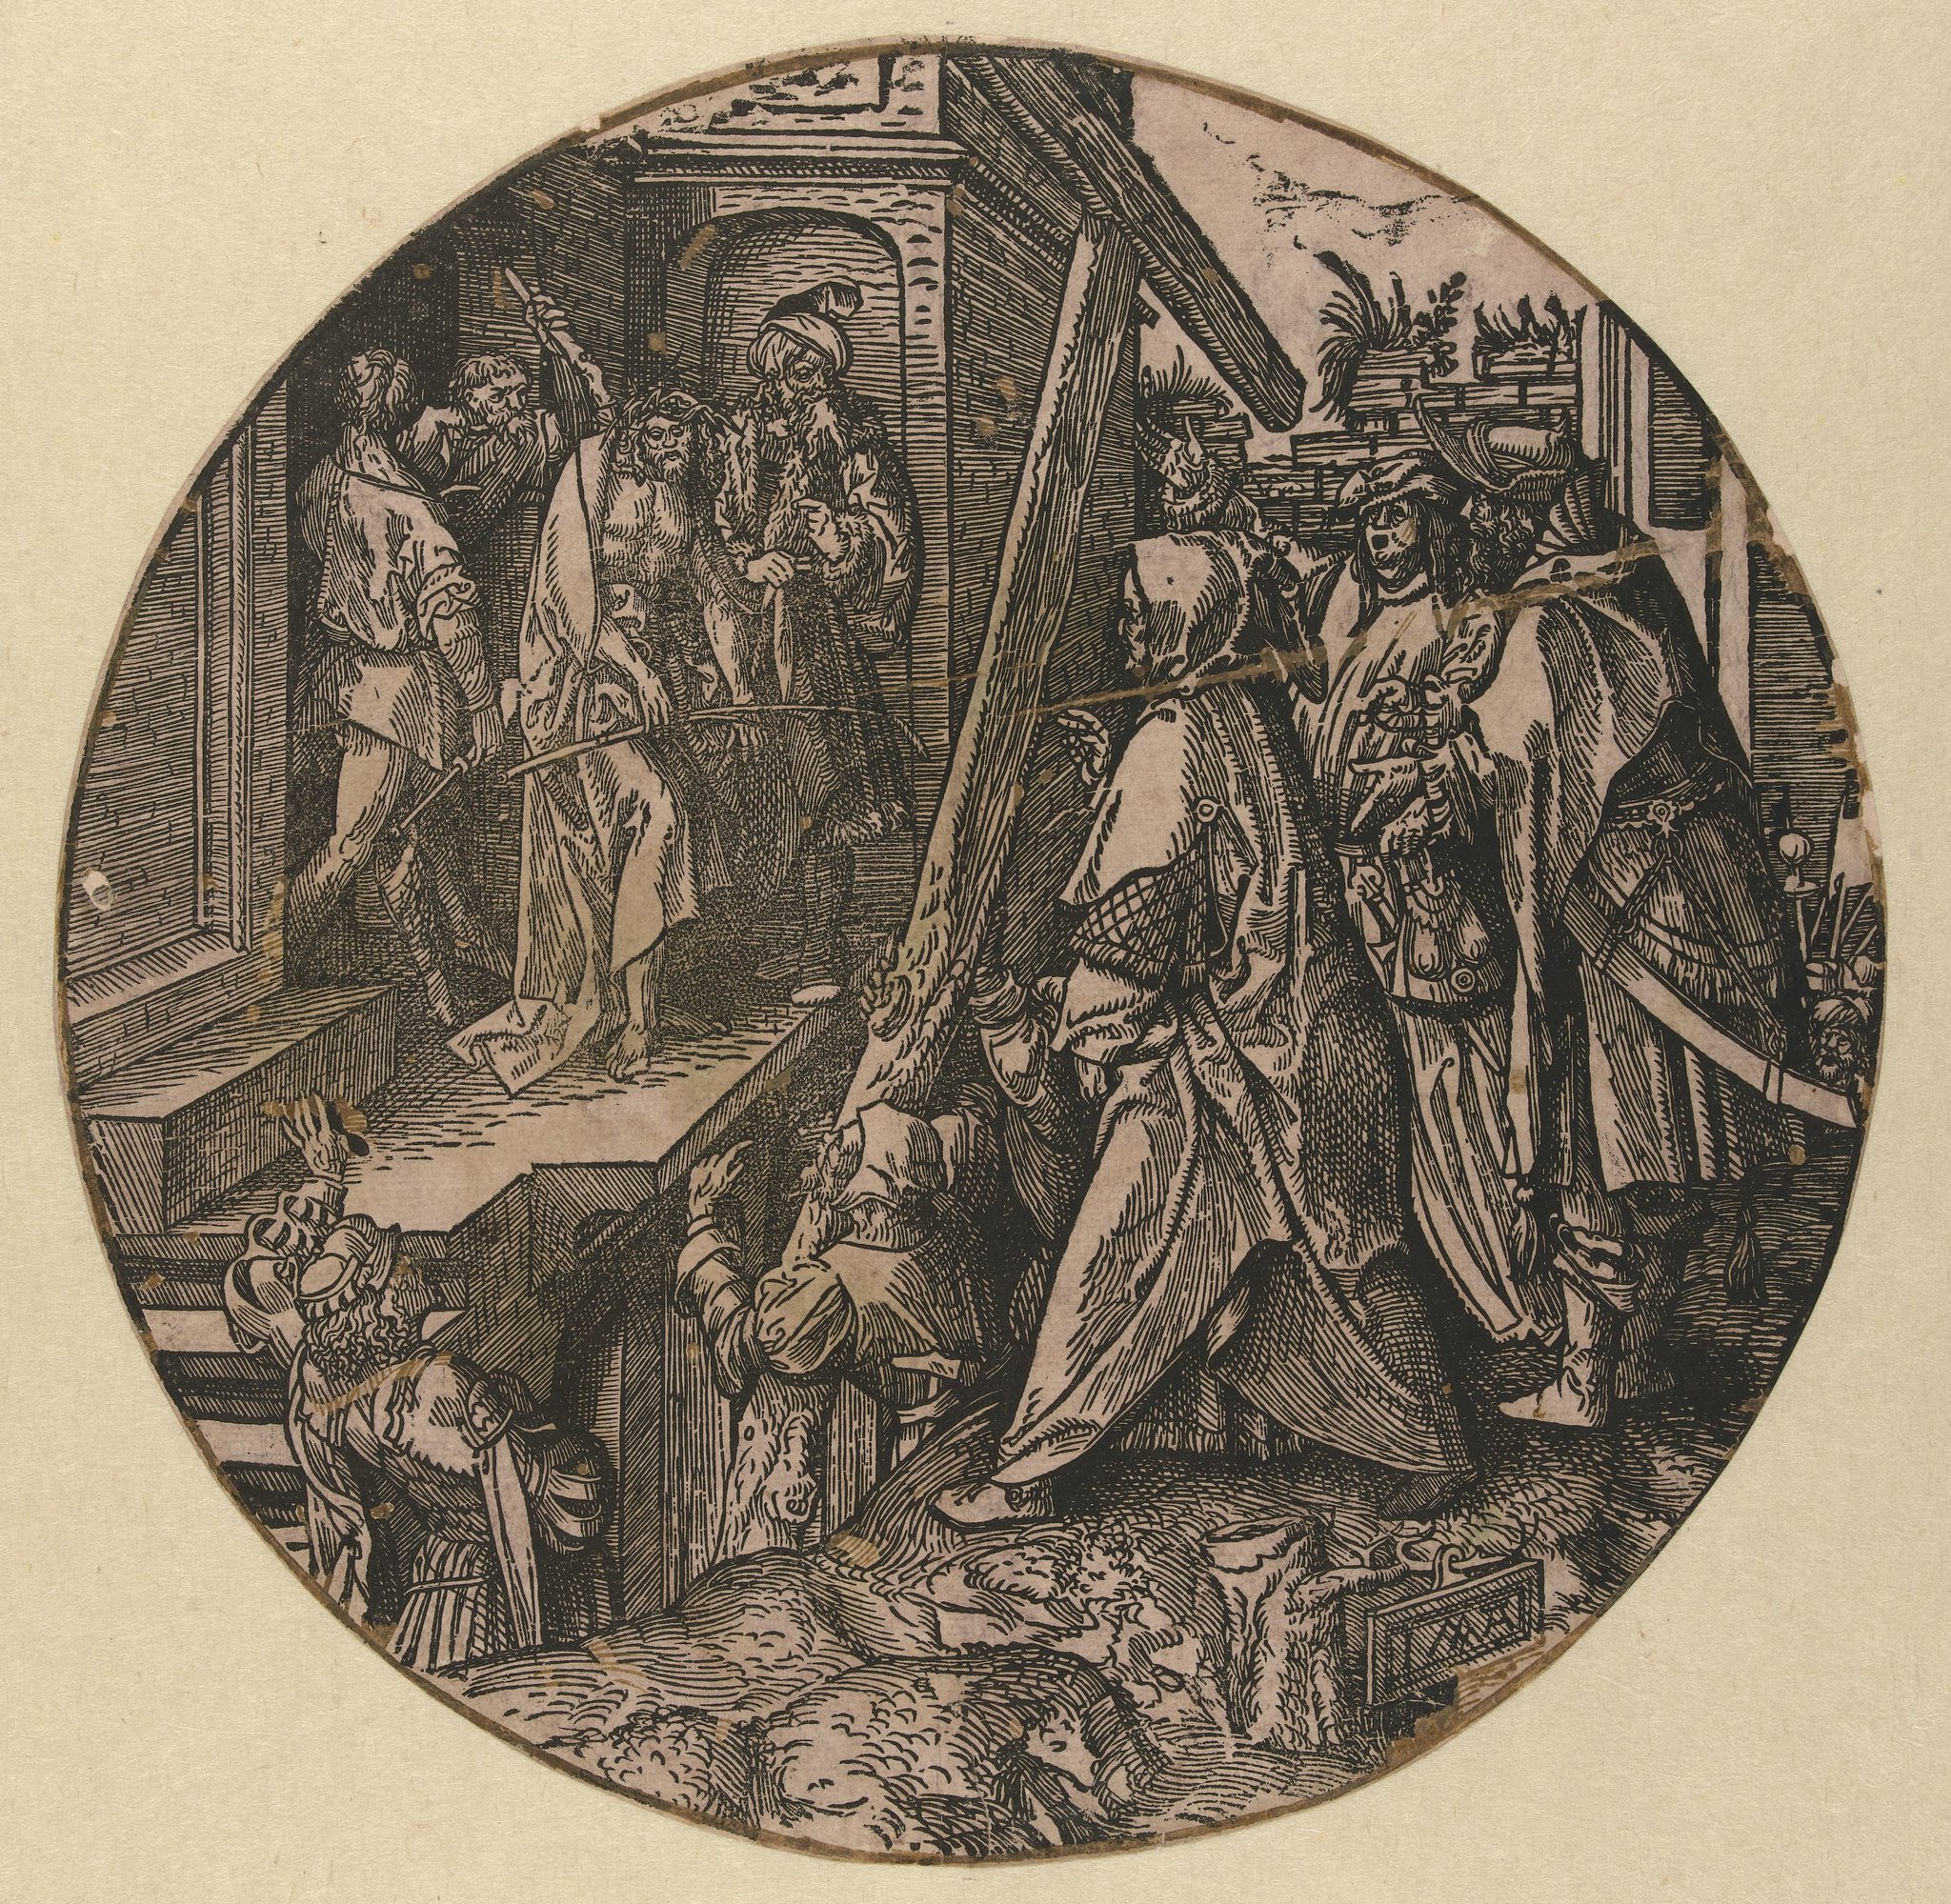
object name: print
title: De Ronde Passie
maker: jacob cornelisz van oostsanen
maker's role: draughtsman, painter, print maker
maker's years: 1475-1533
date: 1517-1533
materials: paper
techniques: pen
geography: low countries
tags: pilate showing christ to the people, 'ostentatio christi', 'ecce homo' (john 19:4-6)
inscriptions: collector's mark: Lugt 2165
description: Uit serie van twaalf prenten. Omlijsting weggesneden. Christus met doornkroon wordt getoond. Man houdt kruis vast, menigte wijst er naar.